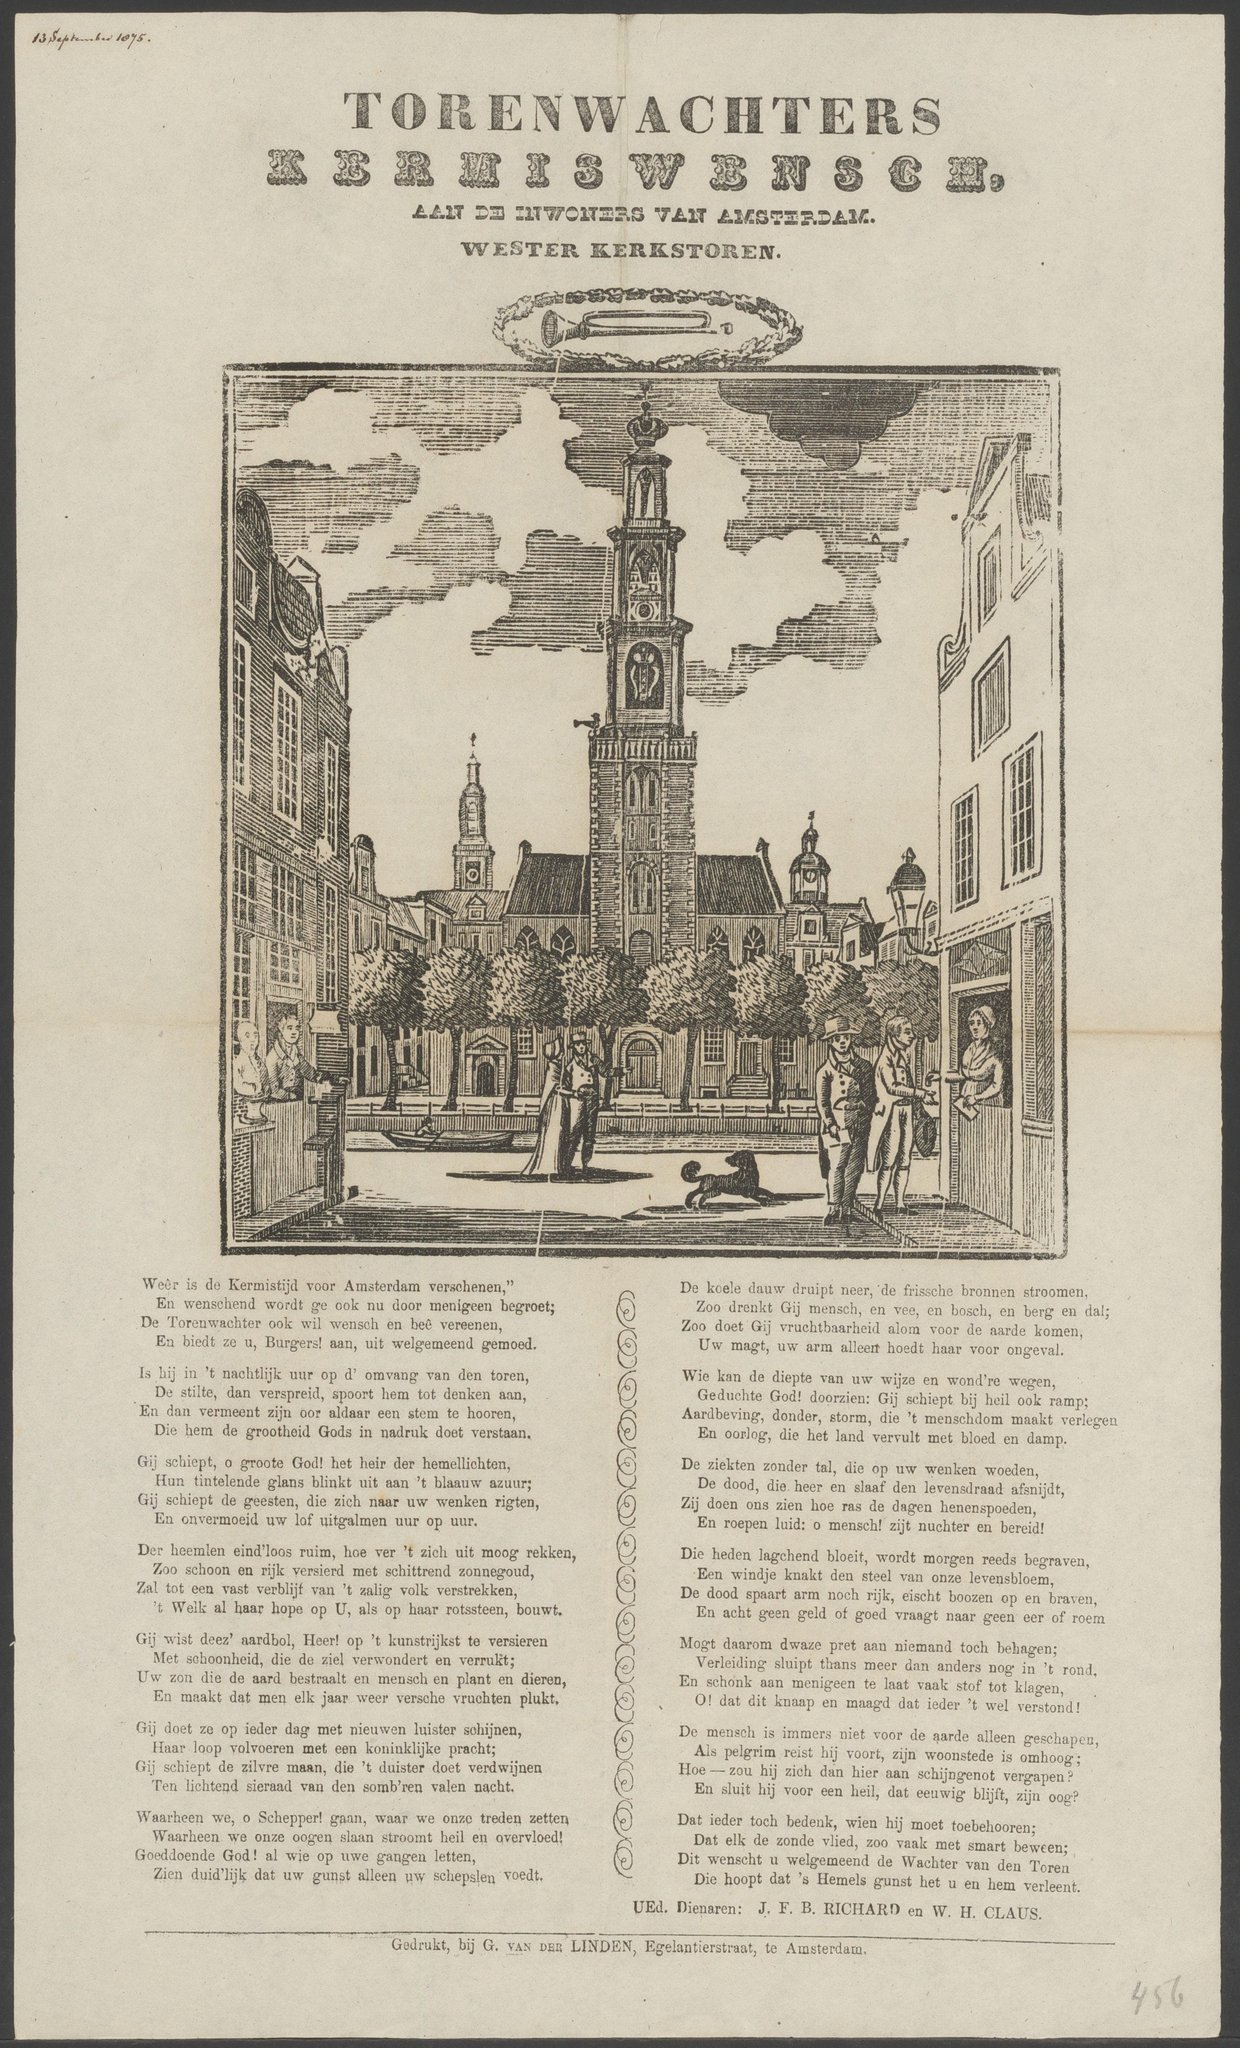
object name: print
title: Torenwachters Kermiswensch aan de inwoners van Amsterdam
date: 1874-1875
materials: paper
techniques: letterpress printing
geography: amsterdam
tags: night patrol, tower (of house or building)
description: Kermiswens van de torenwachters van de stad Amsterdam. Bovenaan een trompet met daaronder een een toren in de stad Amterdam met een torenwachter. Onderaan een vers in twee kolommen. Aangeboden door de torenwachters van de toren van de Westerkerk: J.F.B. Richard en W.H. Claus. Onderwerpsrubrieken binnen de Atlas Zeden en Gewoonten: Zeden en gewoonten in engeren zin, Volksleven, Volksbladen, Nieuwjaars- en Kerstwenschen, Amsterdam.